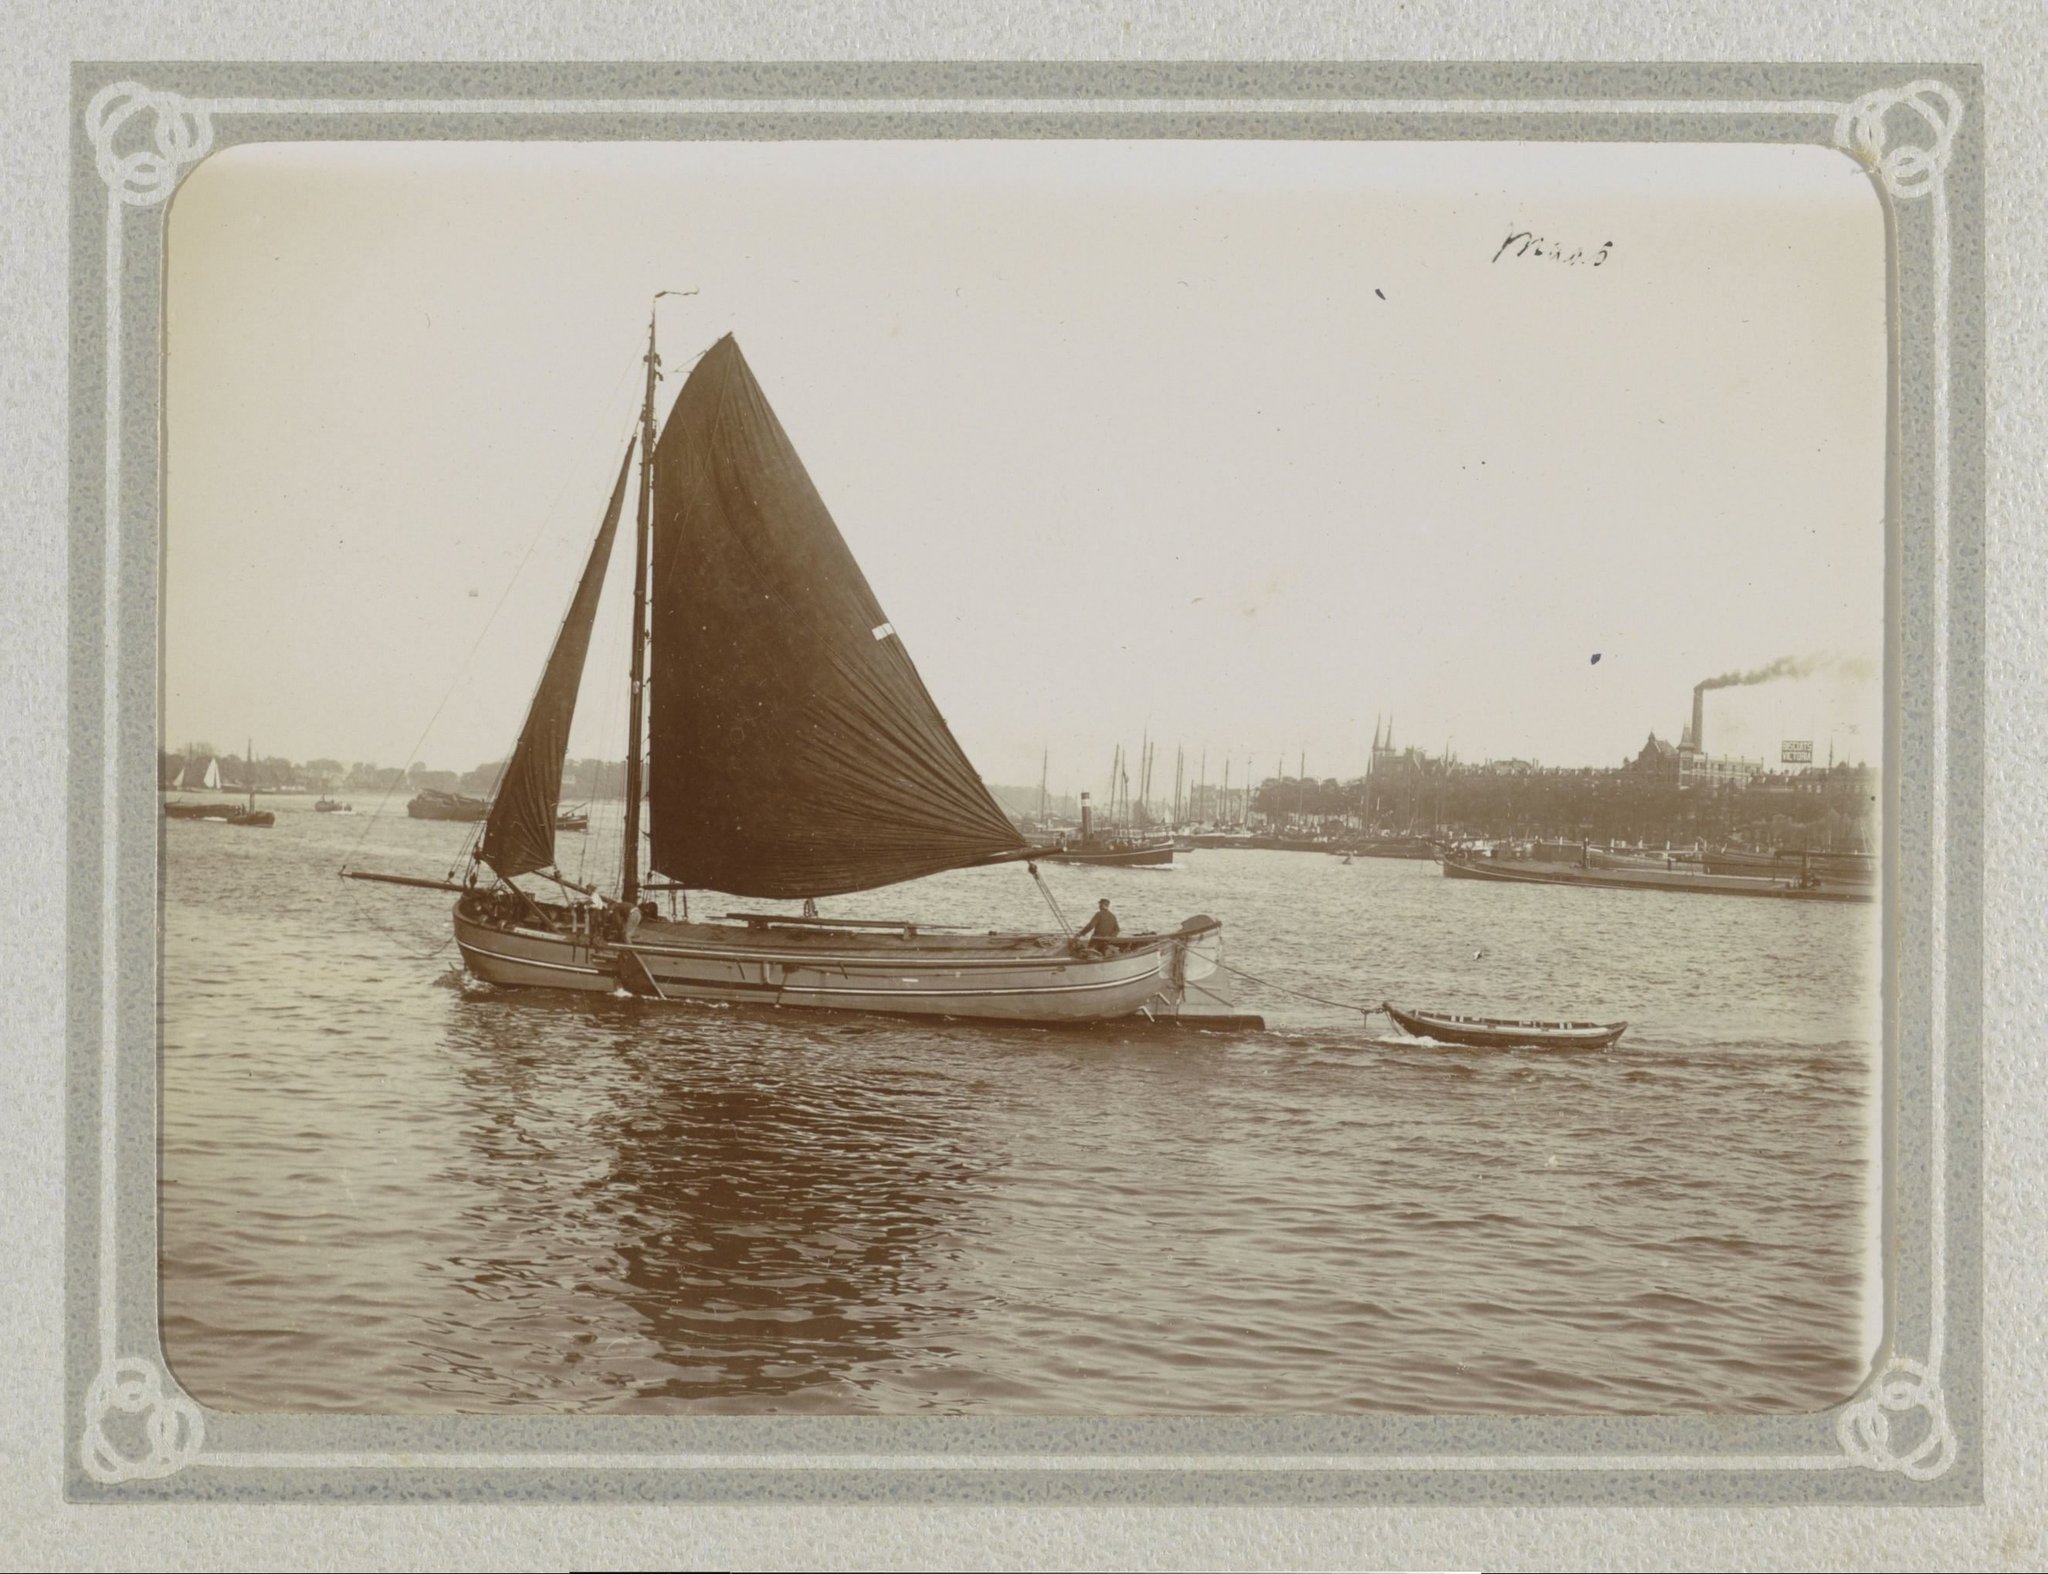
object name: photograph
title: Zeilschip met een sloep op de Maas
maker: folkert idzes de jong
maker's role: architect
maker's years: 1877-1929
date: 1905-1907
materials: photographic support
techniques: gelatin silver print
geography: meuse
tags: sailing-ship, sailing-boat, river, netherlands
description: Onderdeel van Topografisch album van Nederlandse dorpen en steden 1905.